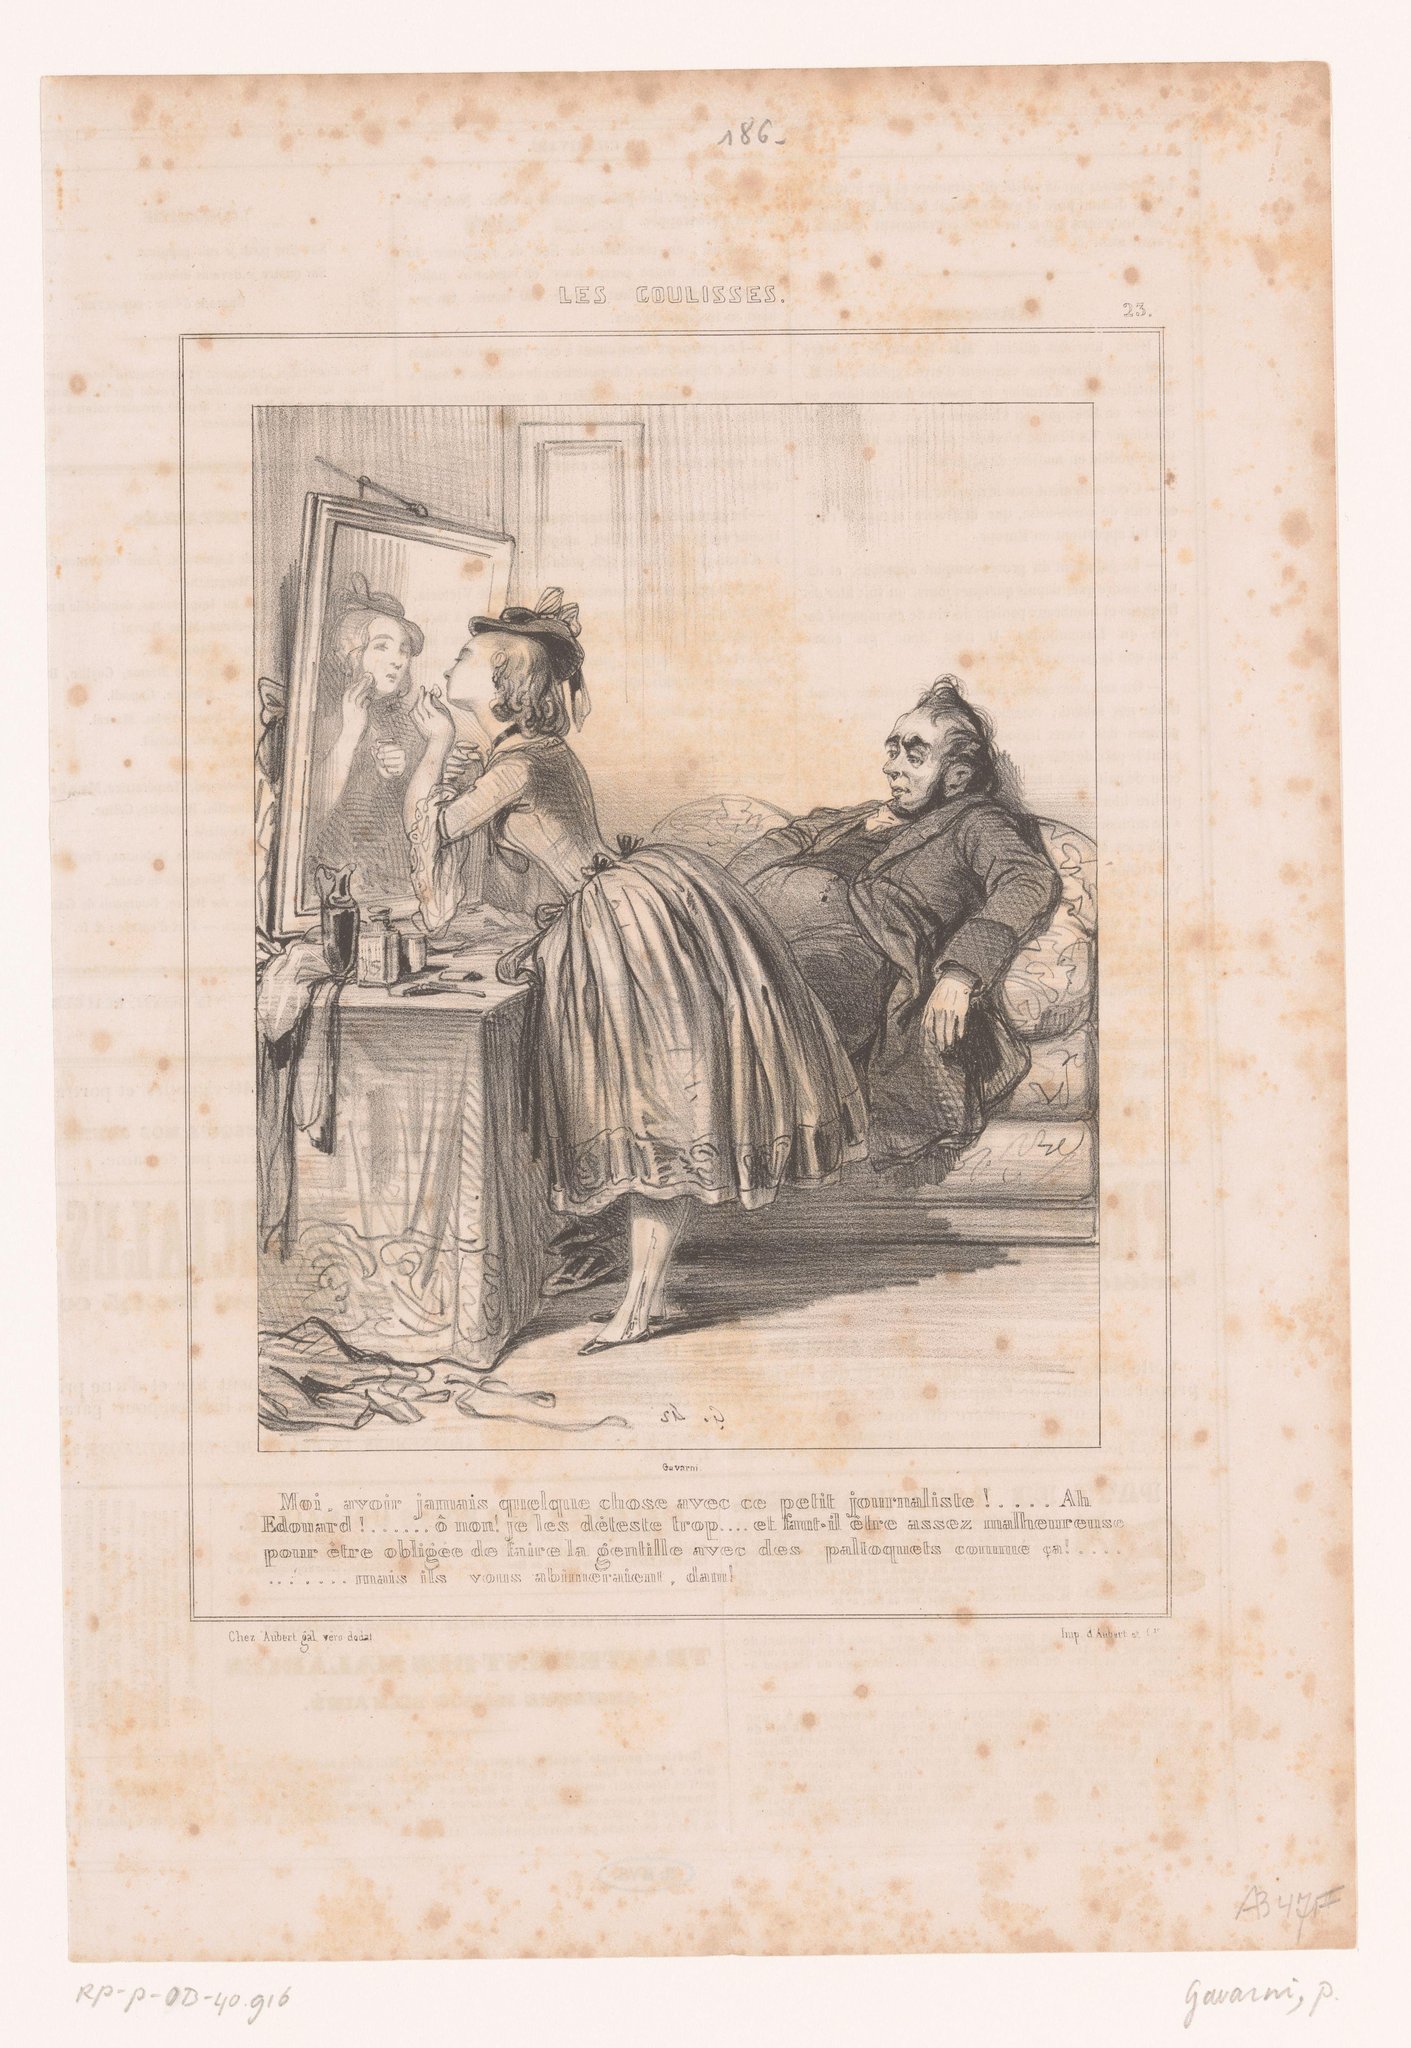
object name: cartoon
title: Jonge actrice maakt zich op voor de spiegel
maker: paul gavarni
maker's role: draughtsman, print maker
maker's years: 1804-1866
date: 1838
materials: paper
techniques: lithograph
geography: paris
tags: artiste in other non-work situation, powder ~ making toilet - aa - (for) women, stage costume - cc - female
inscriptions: collector's mark: Lugt 2228a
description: Prent gebruikt voor: Le Charivari, 7 juli 1838.